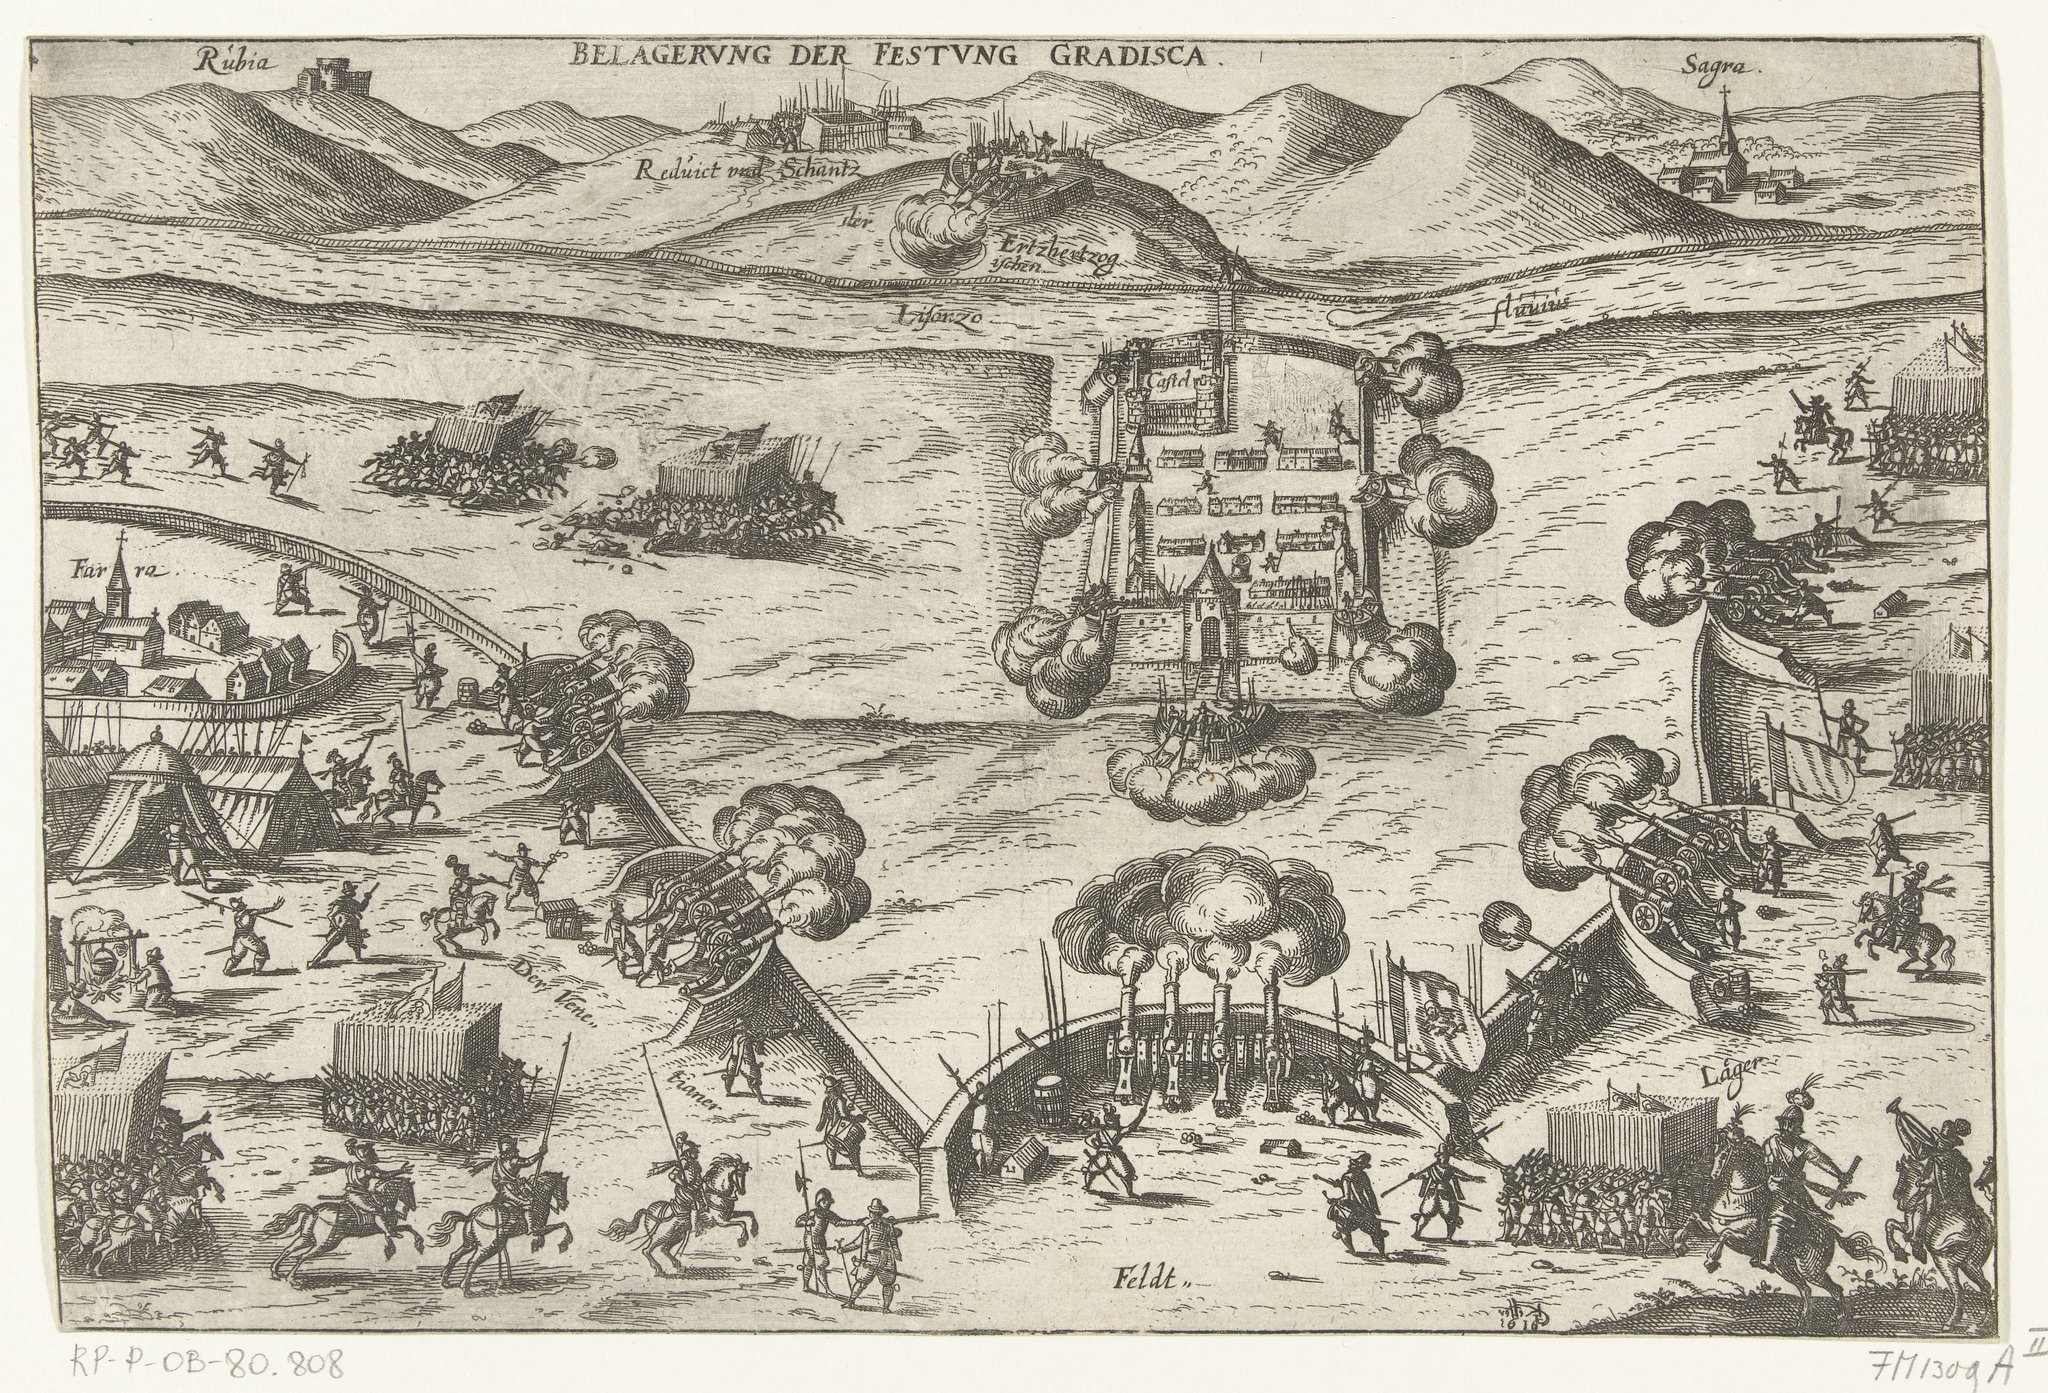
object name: print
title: Beleg van de vesting Gradisca, 1616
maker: georg keller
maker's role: print maker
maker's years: 1568-1634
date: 1616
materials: paper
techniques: etching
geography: germany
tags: johan ernst i graaf van nassau-siegen, siege, position war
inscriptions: date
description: Beleg van de vesting Gradisca, aan de rivier Livenzo boven Venetië, door de troepen onder Johan Ernst I, graaf van Nassau-Siegen, 1616.